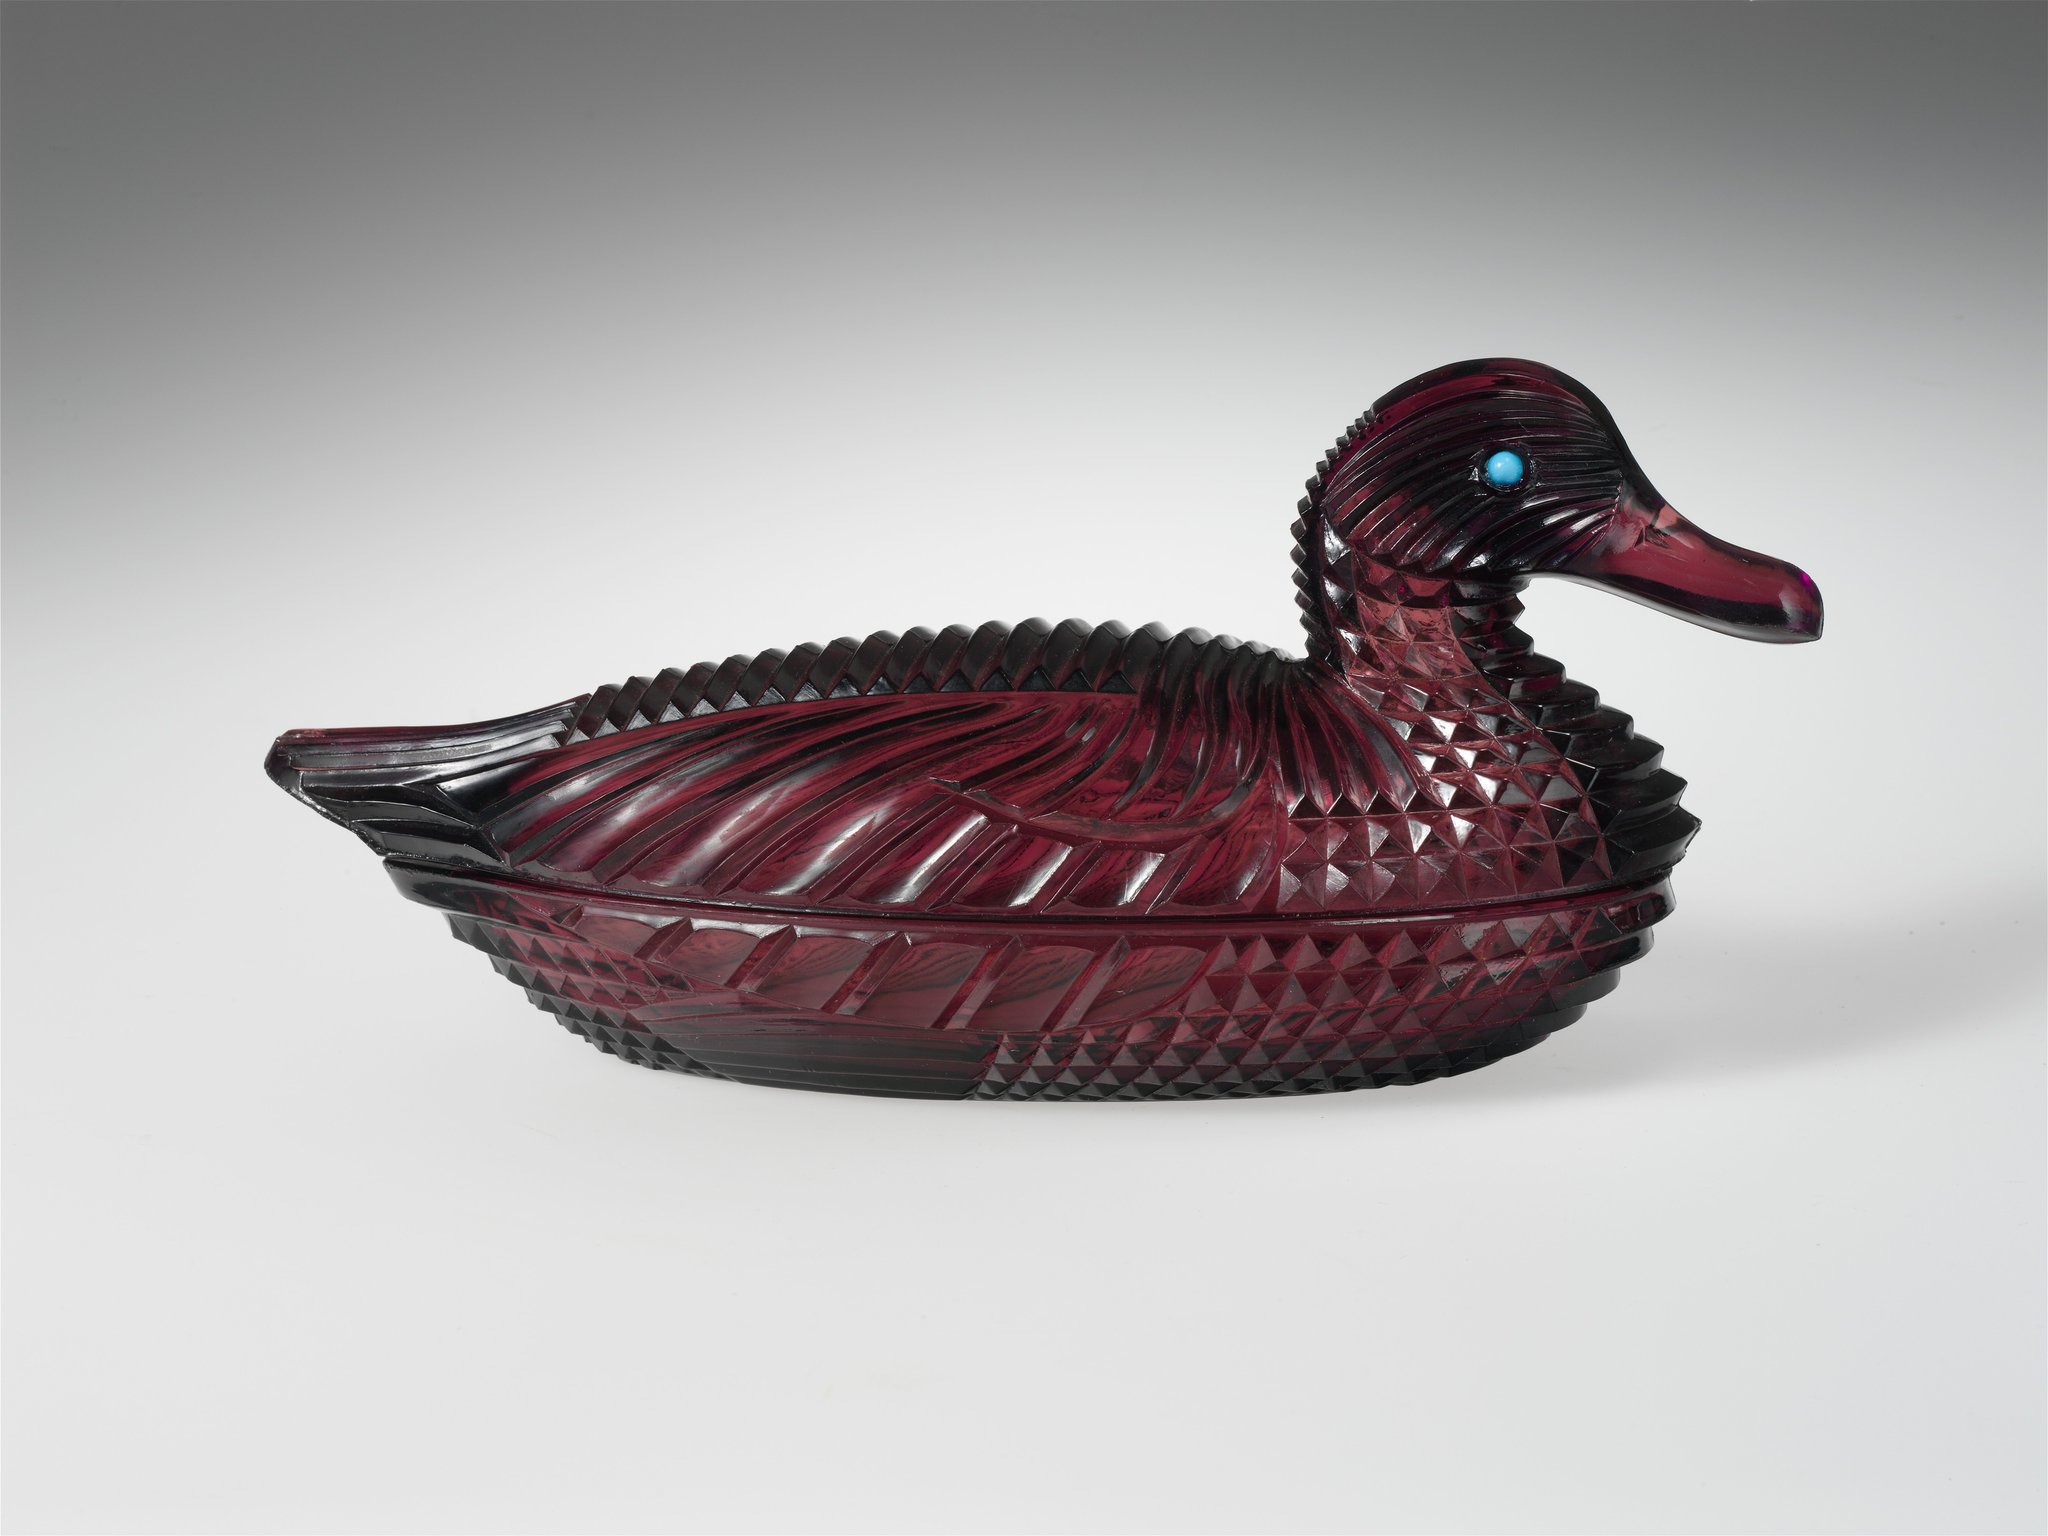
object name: dish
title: Covered Figural Dish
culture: american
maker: atterbury and company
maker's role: maker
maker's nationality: american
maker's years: 1864-1893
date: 1887-1890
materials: gemstone, glass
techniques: pressed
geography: united states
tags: ducks